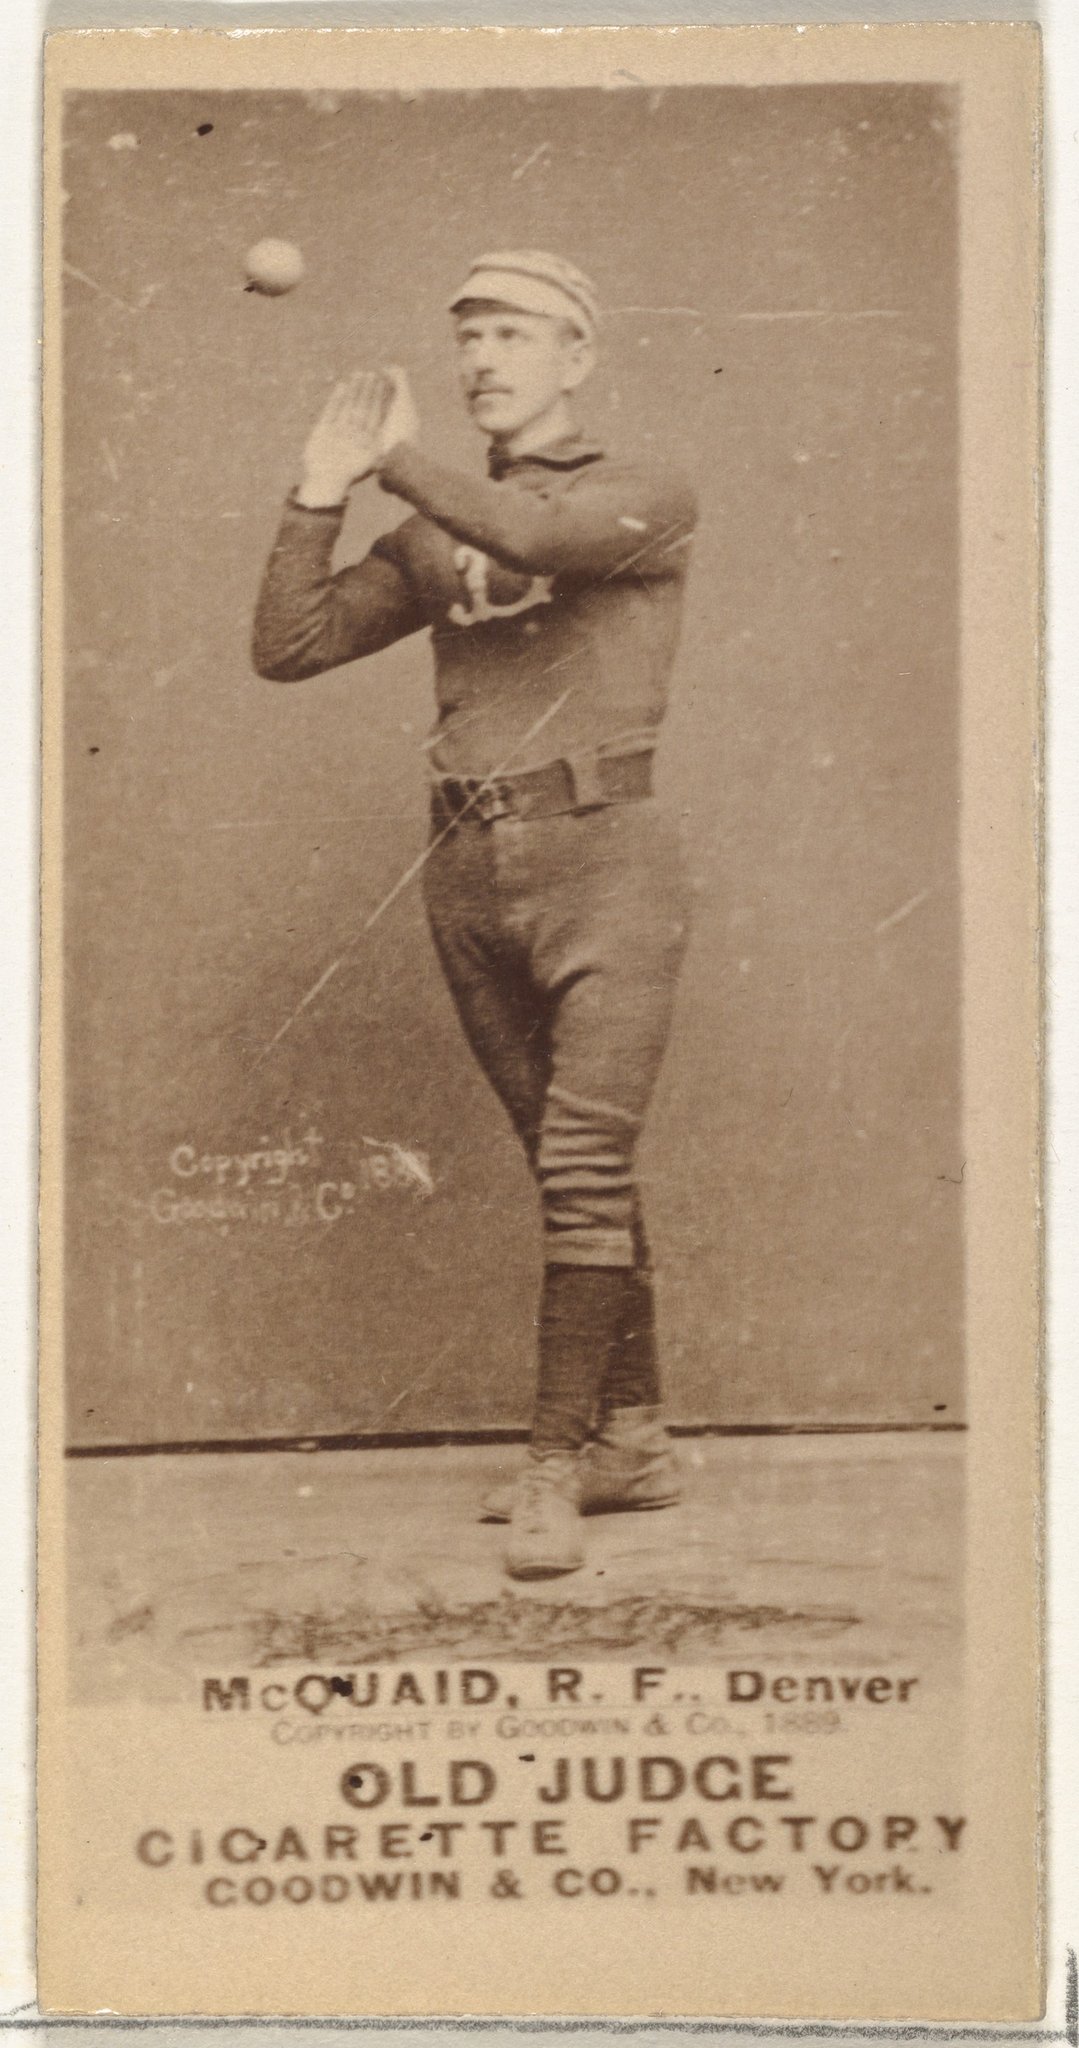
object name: baseball card, photograph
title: Mortimer Martin "Mart" McQuaid, Right Field, Denver, from the Old Judge series (N172) for Old Judge Cigarettes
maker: goodwin & company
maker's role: publisher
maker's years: 1850-1950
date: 1889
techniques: albumen silver print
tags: men,portraits,baseball,athletes